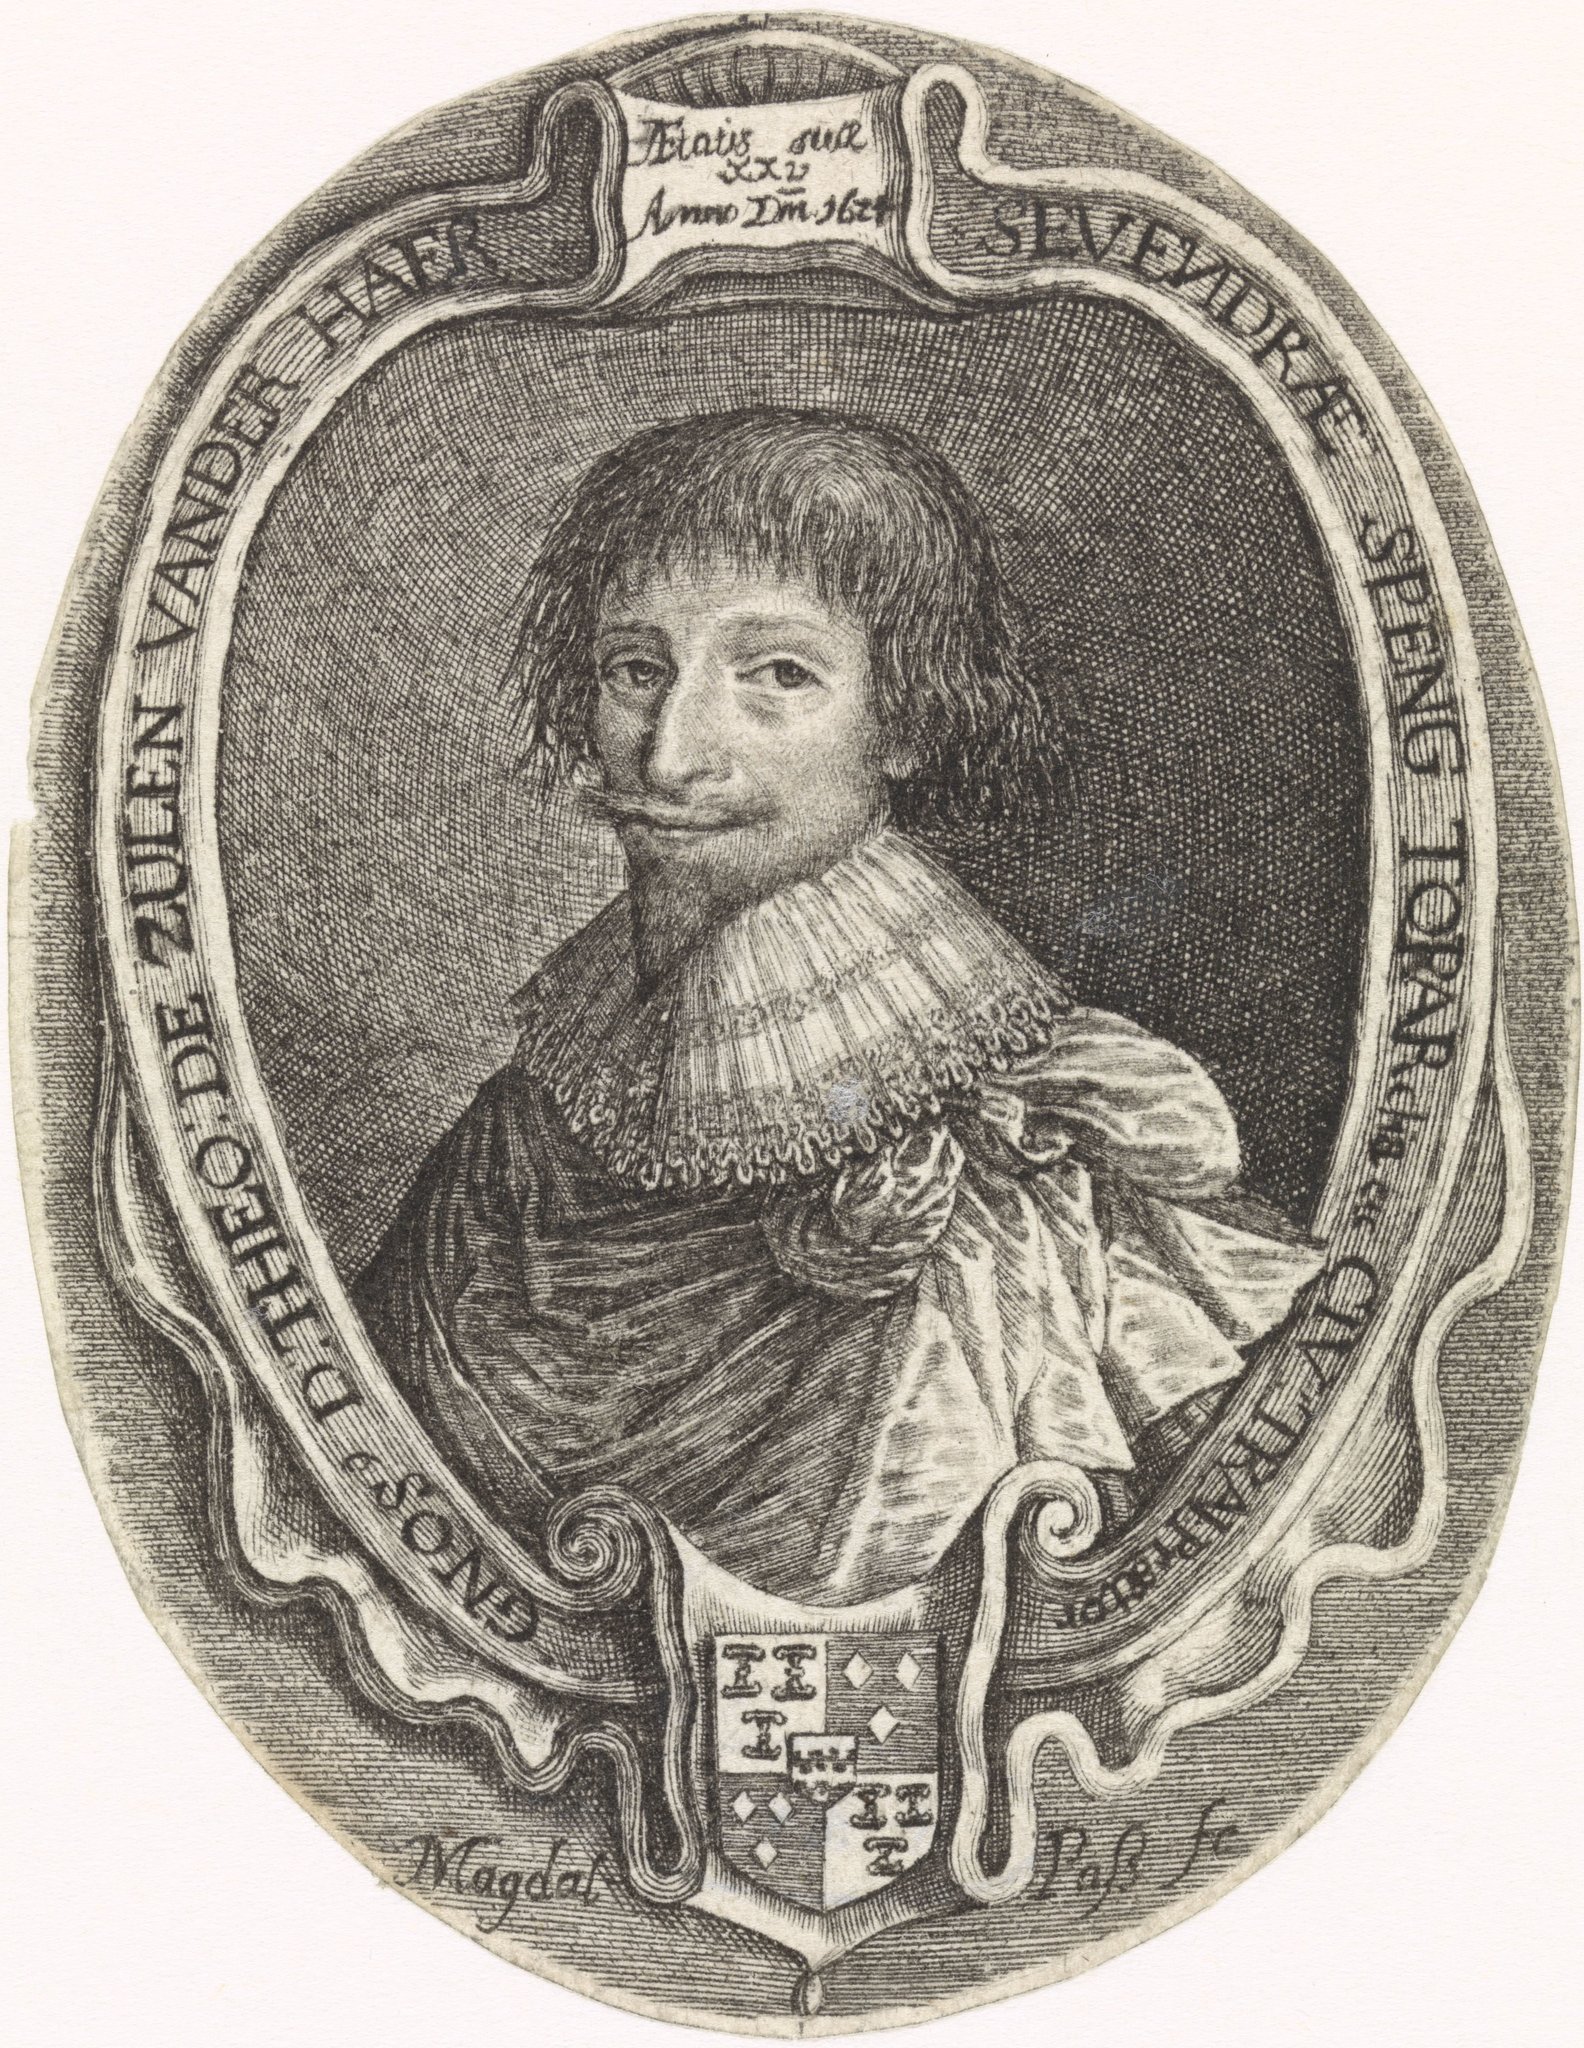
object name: print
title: Portraits of Armgaert Elisabeth van Dort van Roosendaal and Theodore van Zuylen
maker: magdalena van de passe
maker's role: print maker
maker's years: 1600-1638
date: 1624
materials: paper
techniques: engraving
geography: utrecht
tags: schout, theodoor van zuylen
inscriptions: collector's mark: Lugt 2228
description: These pendant portraits show a man and a woman in the prime of their lives: Elisabeth van Dort van Roosendaal and her betrothed Theodoor van Zuylen, were 23 and 24 years old and recently engaged. However, it would not come from a marriage due to Theodoor's premature death. Presumably Elisabeth had the portraits made in memory of her beloved.